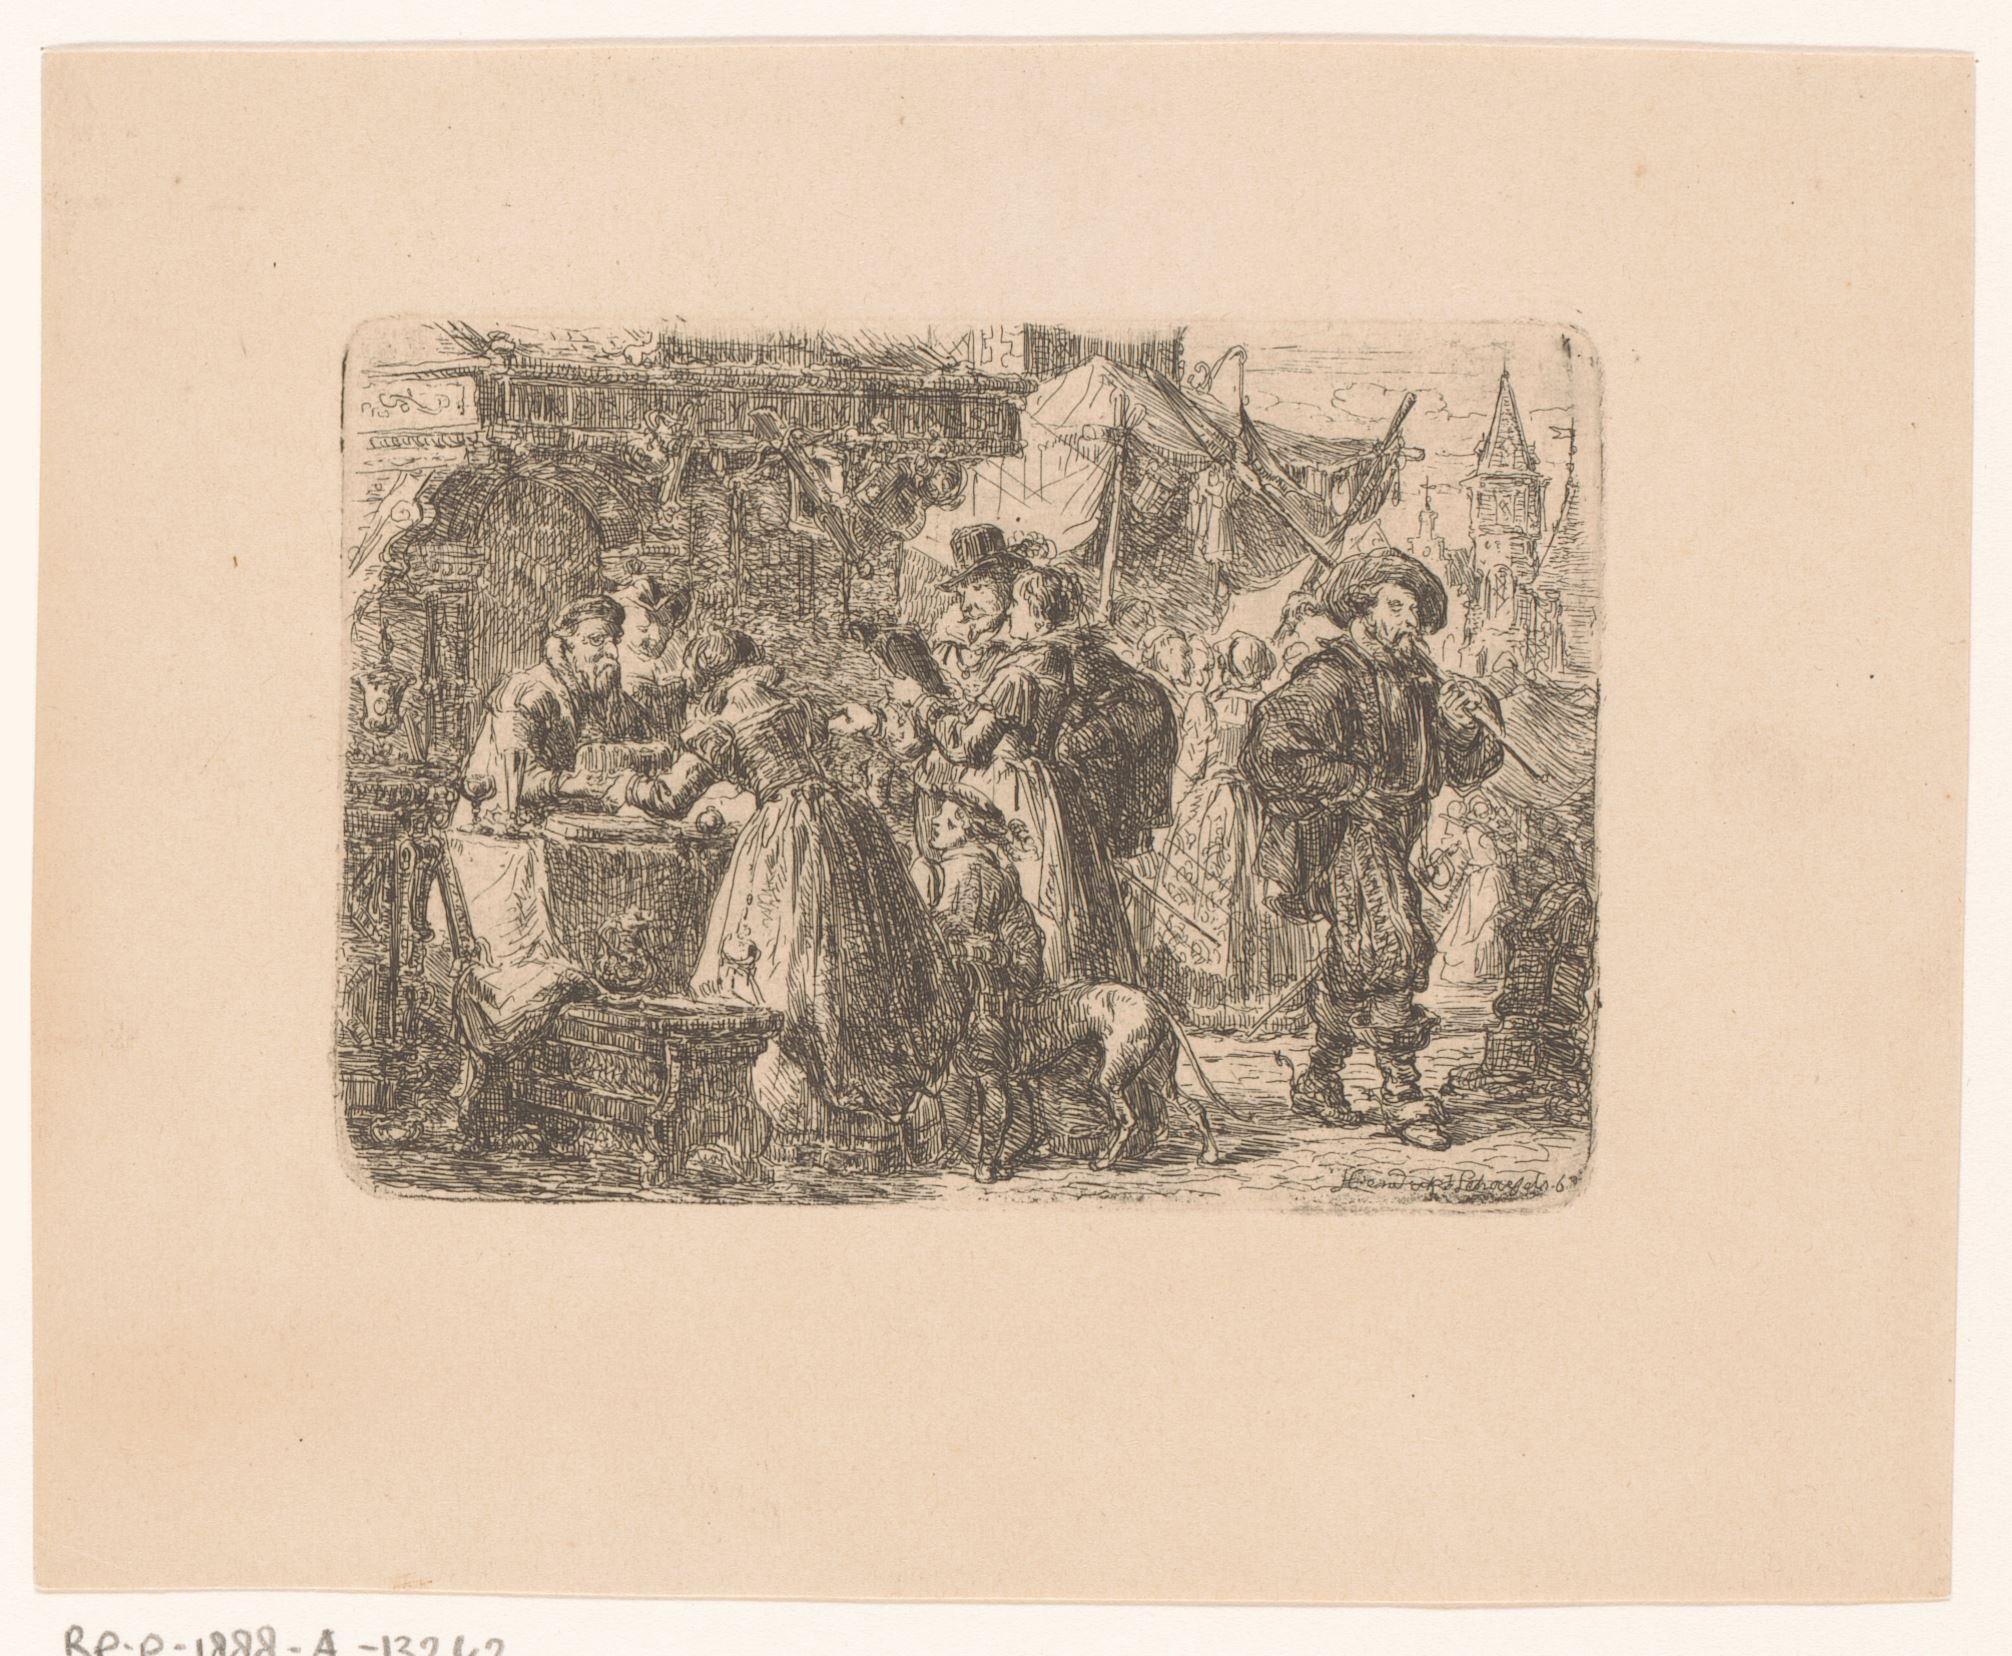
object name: print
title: Figuren bij een winkelkraam op een markt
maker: henri françois schaefels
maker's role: print maker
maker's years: 1827-1904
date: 1862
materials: paper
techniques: etching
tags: shop, store, market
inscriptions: collector's mark: Lugt 2228